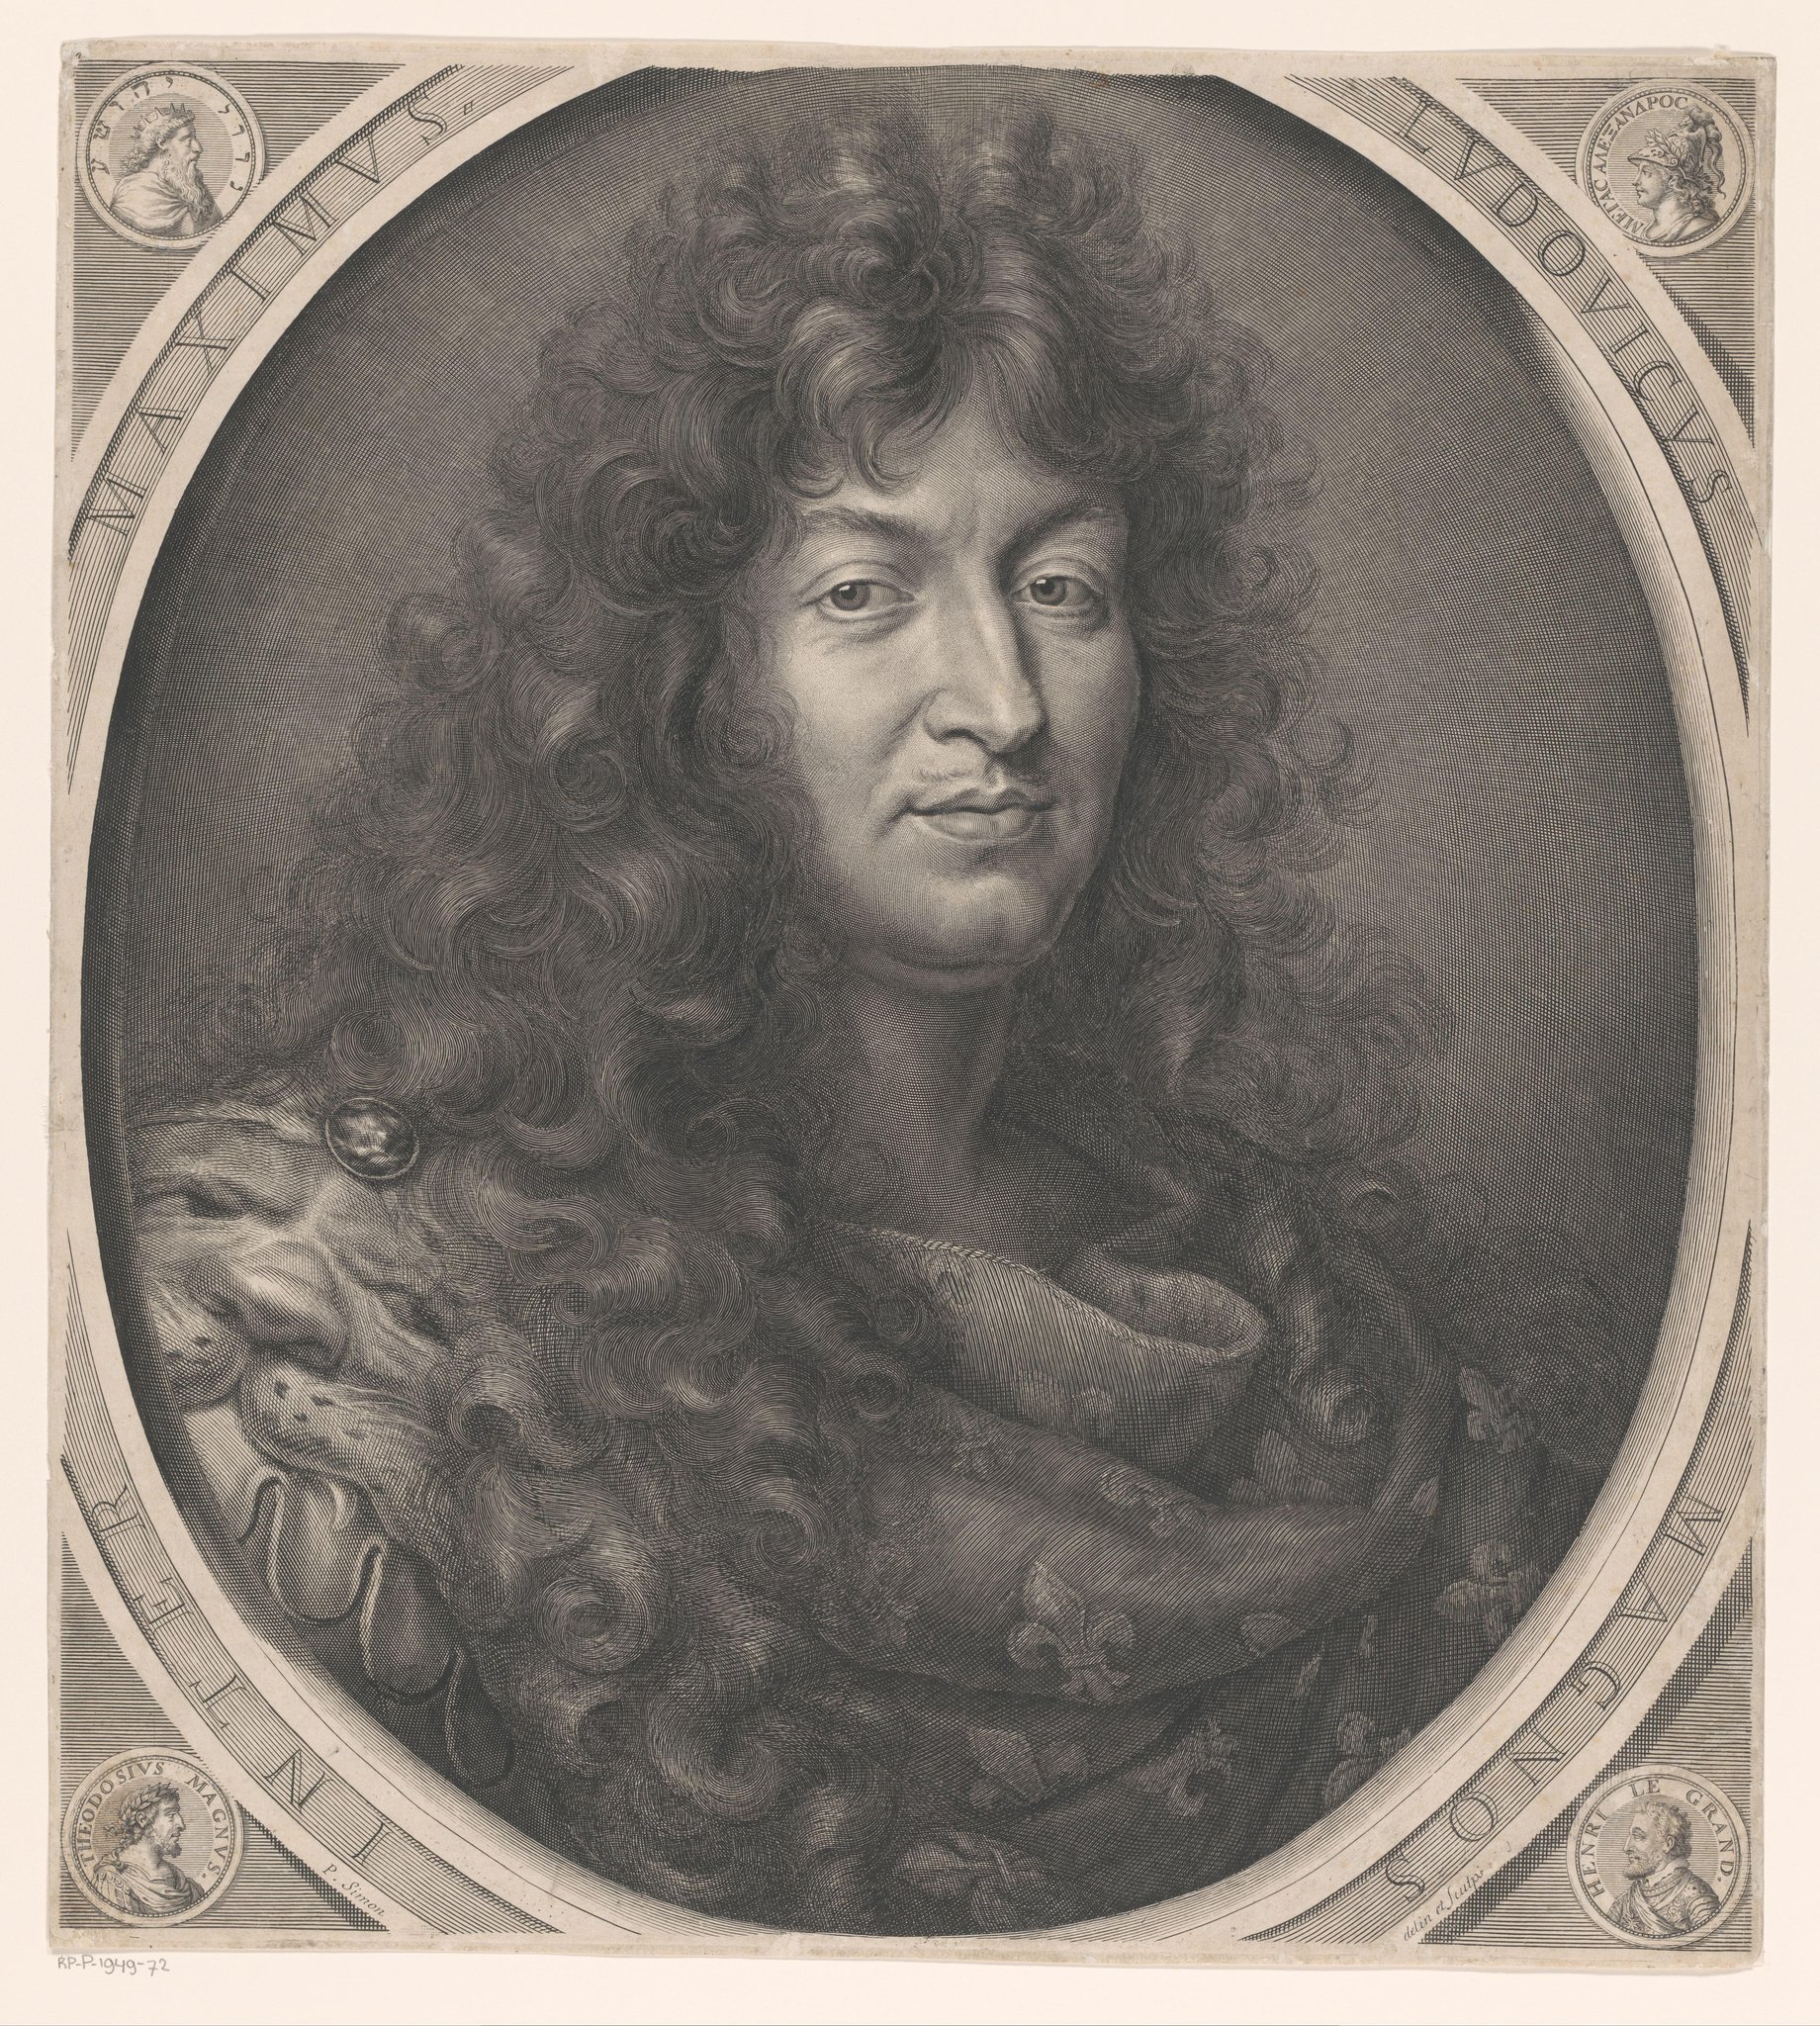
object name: print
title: Portret van Lodewijk XIV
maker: pierre simon (i)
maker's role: print maker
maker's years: 1640-1710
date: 1650-1715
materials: paper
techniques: engraving, etching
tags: lodewijk xiv (koning van frankrijk), historical persons, king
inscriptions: collector's mark: Lugt 2228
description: Portret omringd door vier kleine portretten van koningen uit de geschiedenis.